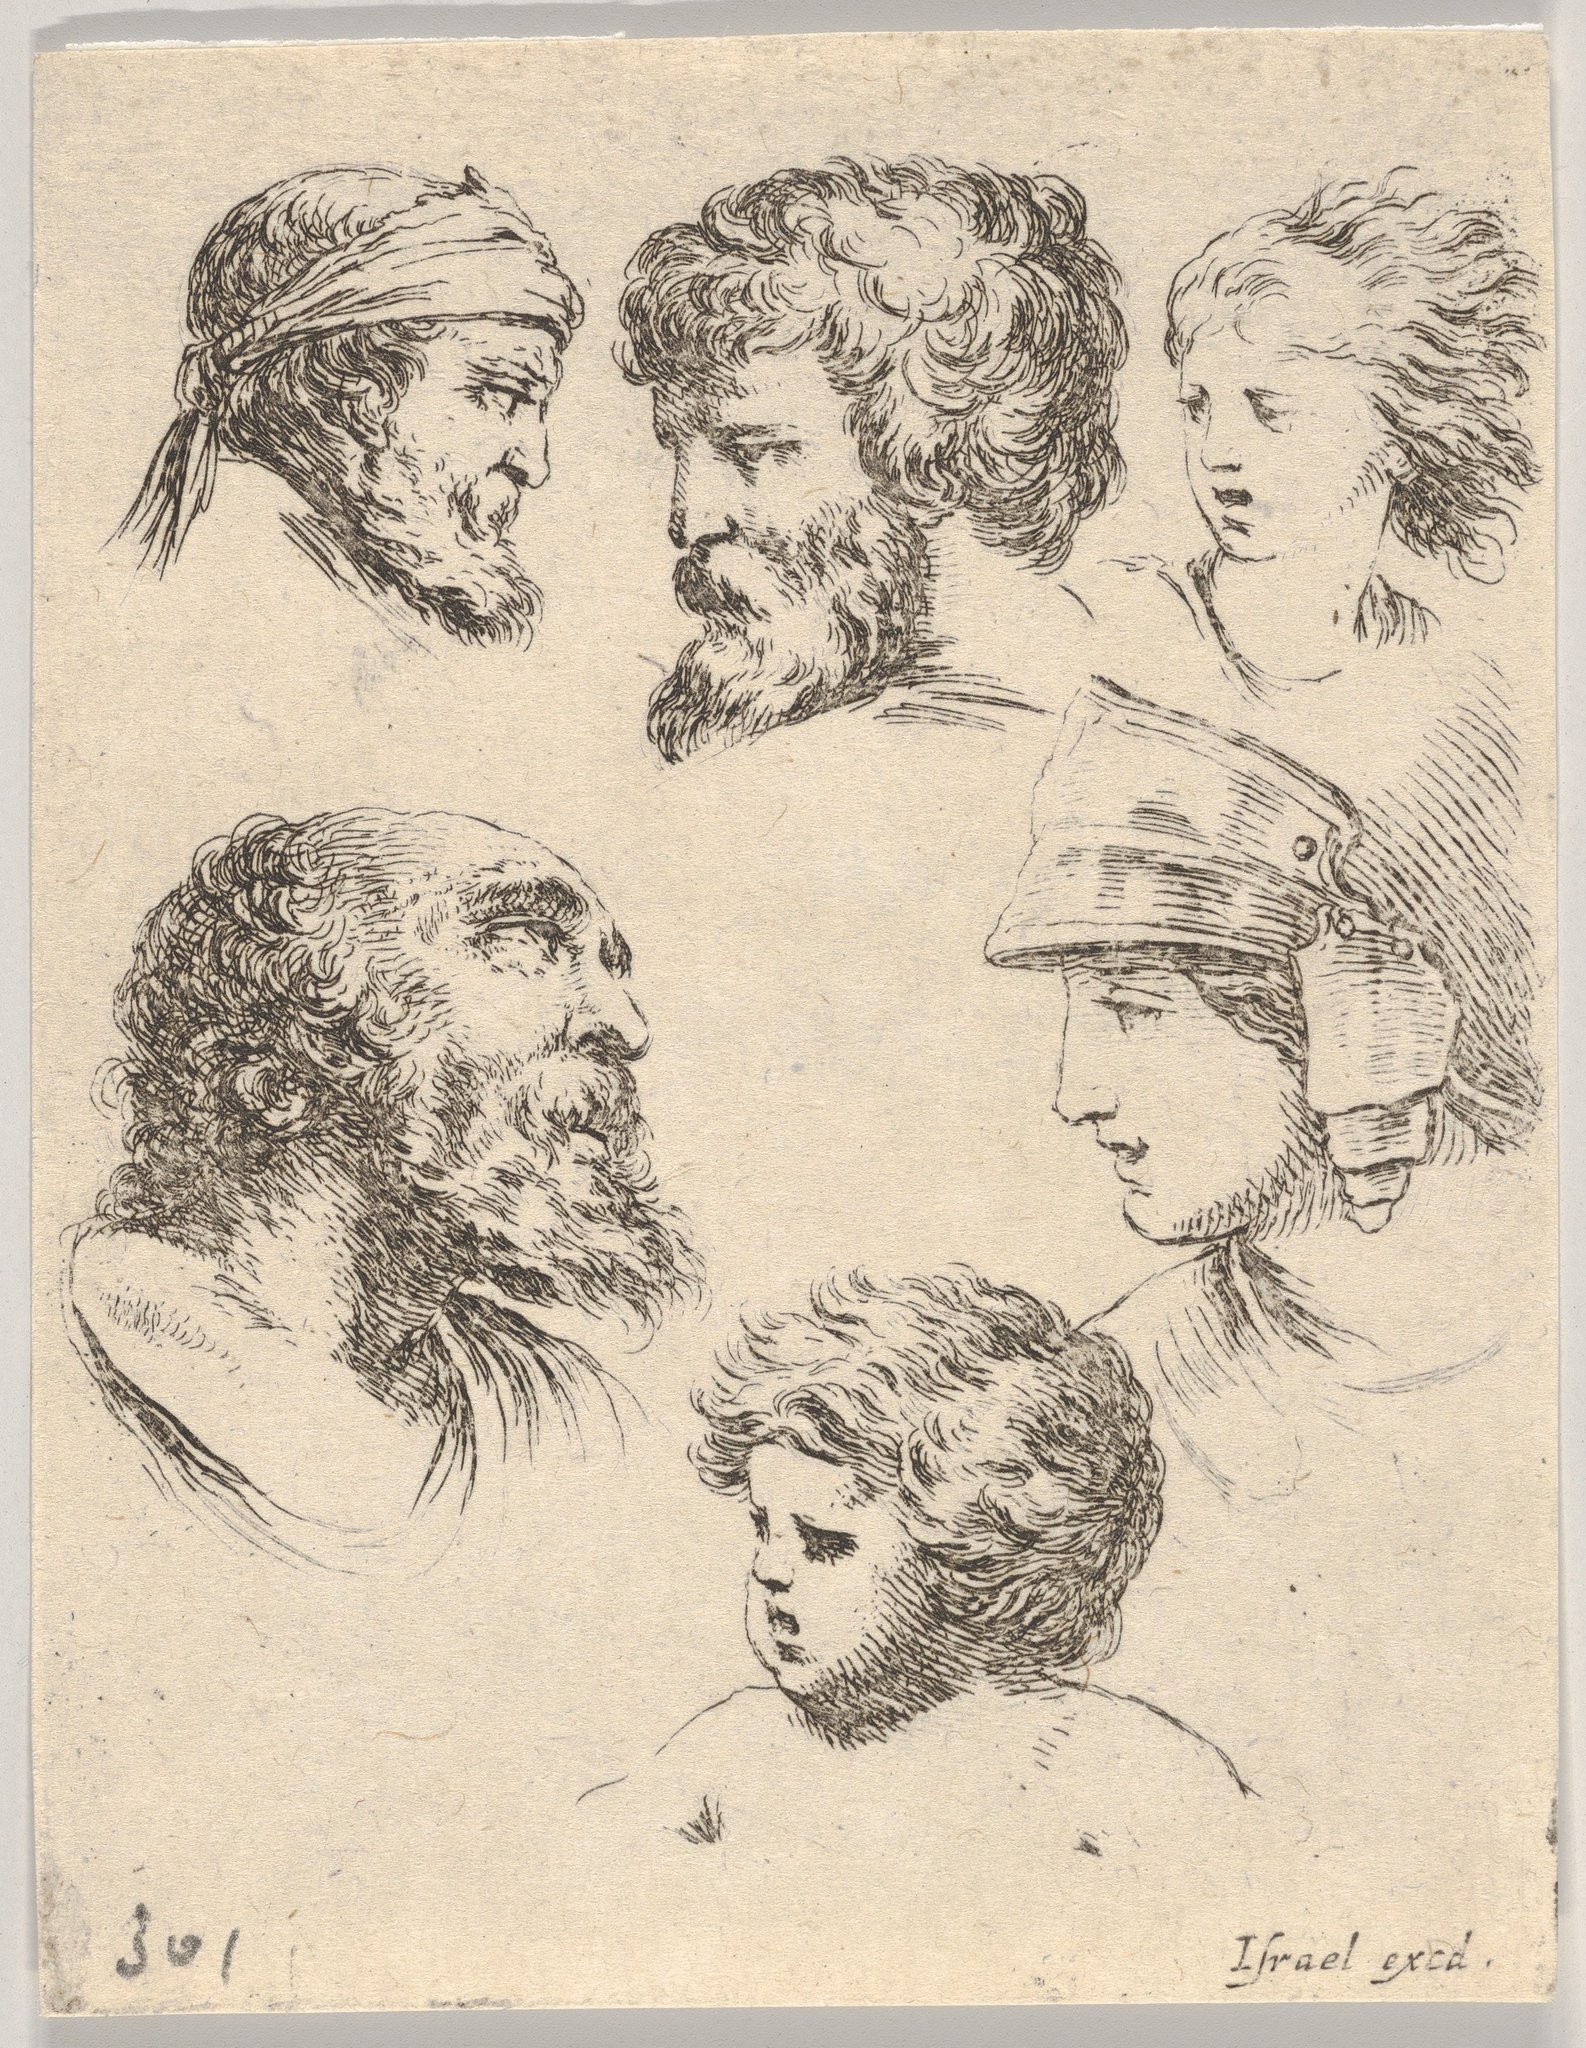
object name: print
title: Plate 10: Six heads, three bearded men, one soldier, and two children, from "The Book for Learning to Draw" (Livre pour apprendre à dessiner)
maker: stefano della bella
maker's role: artist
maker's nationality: italian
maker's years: 1610-1664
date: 1649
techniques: etching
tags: soldiers,heads,children,men